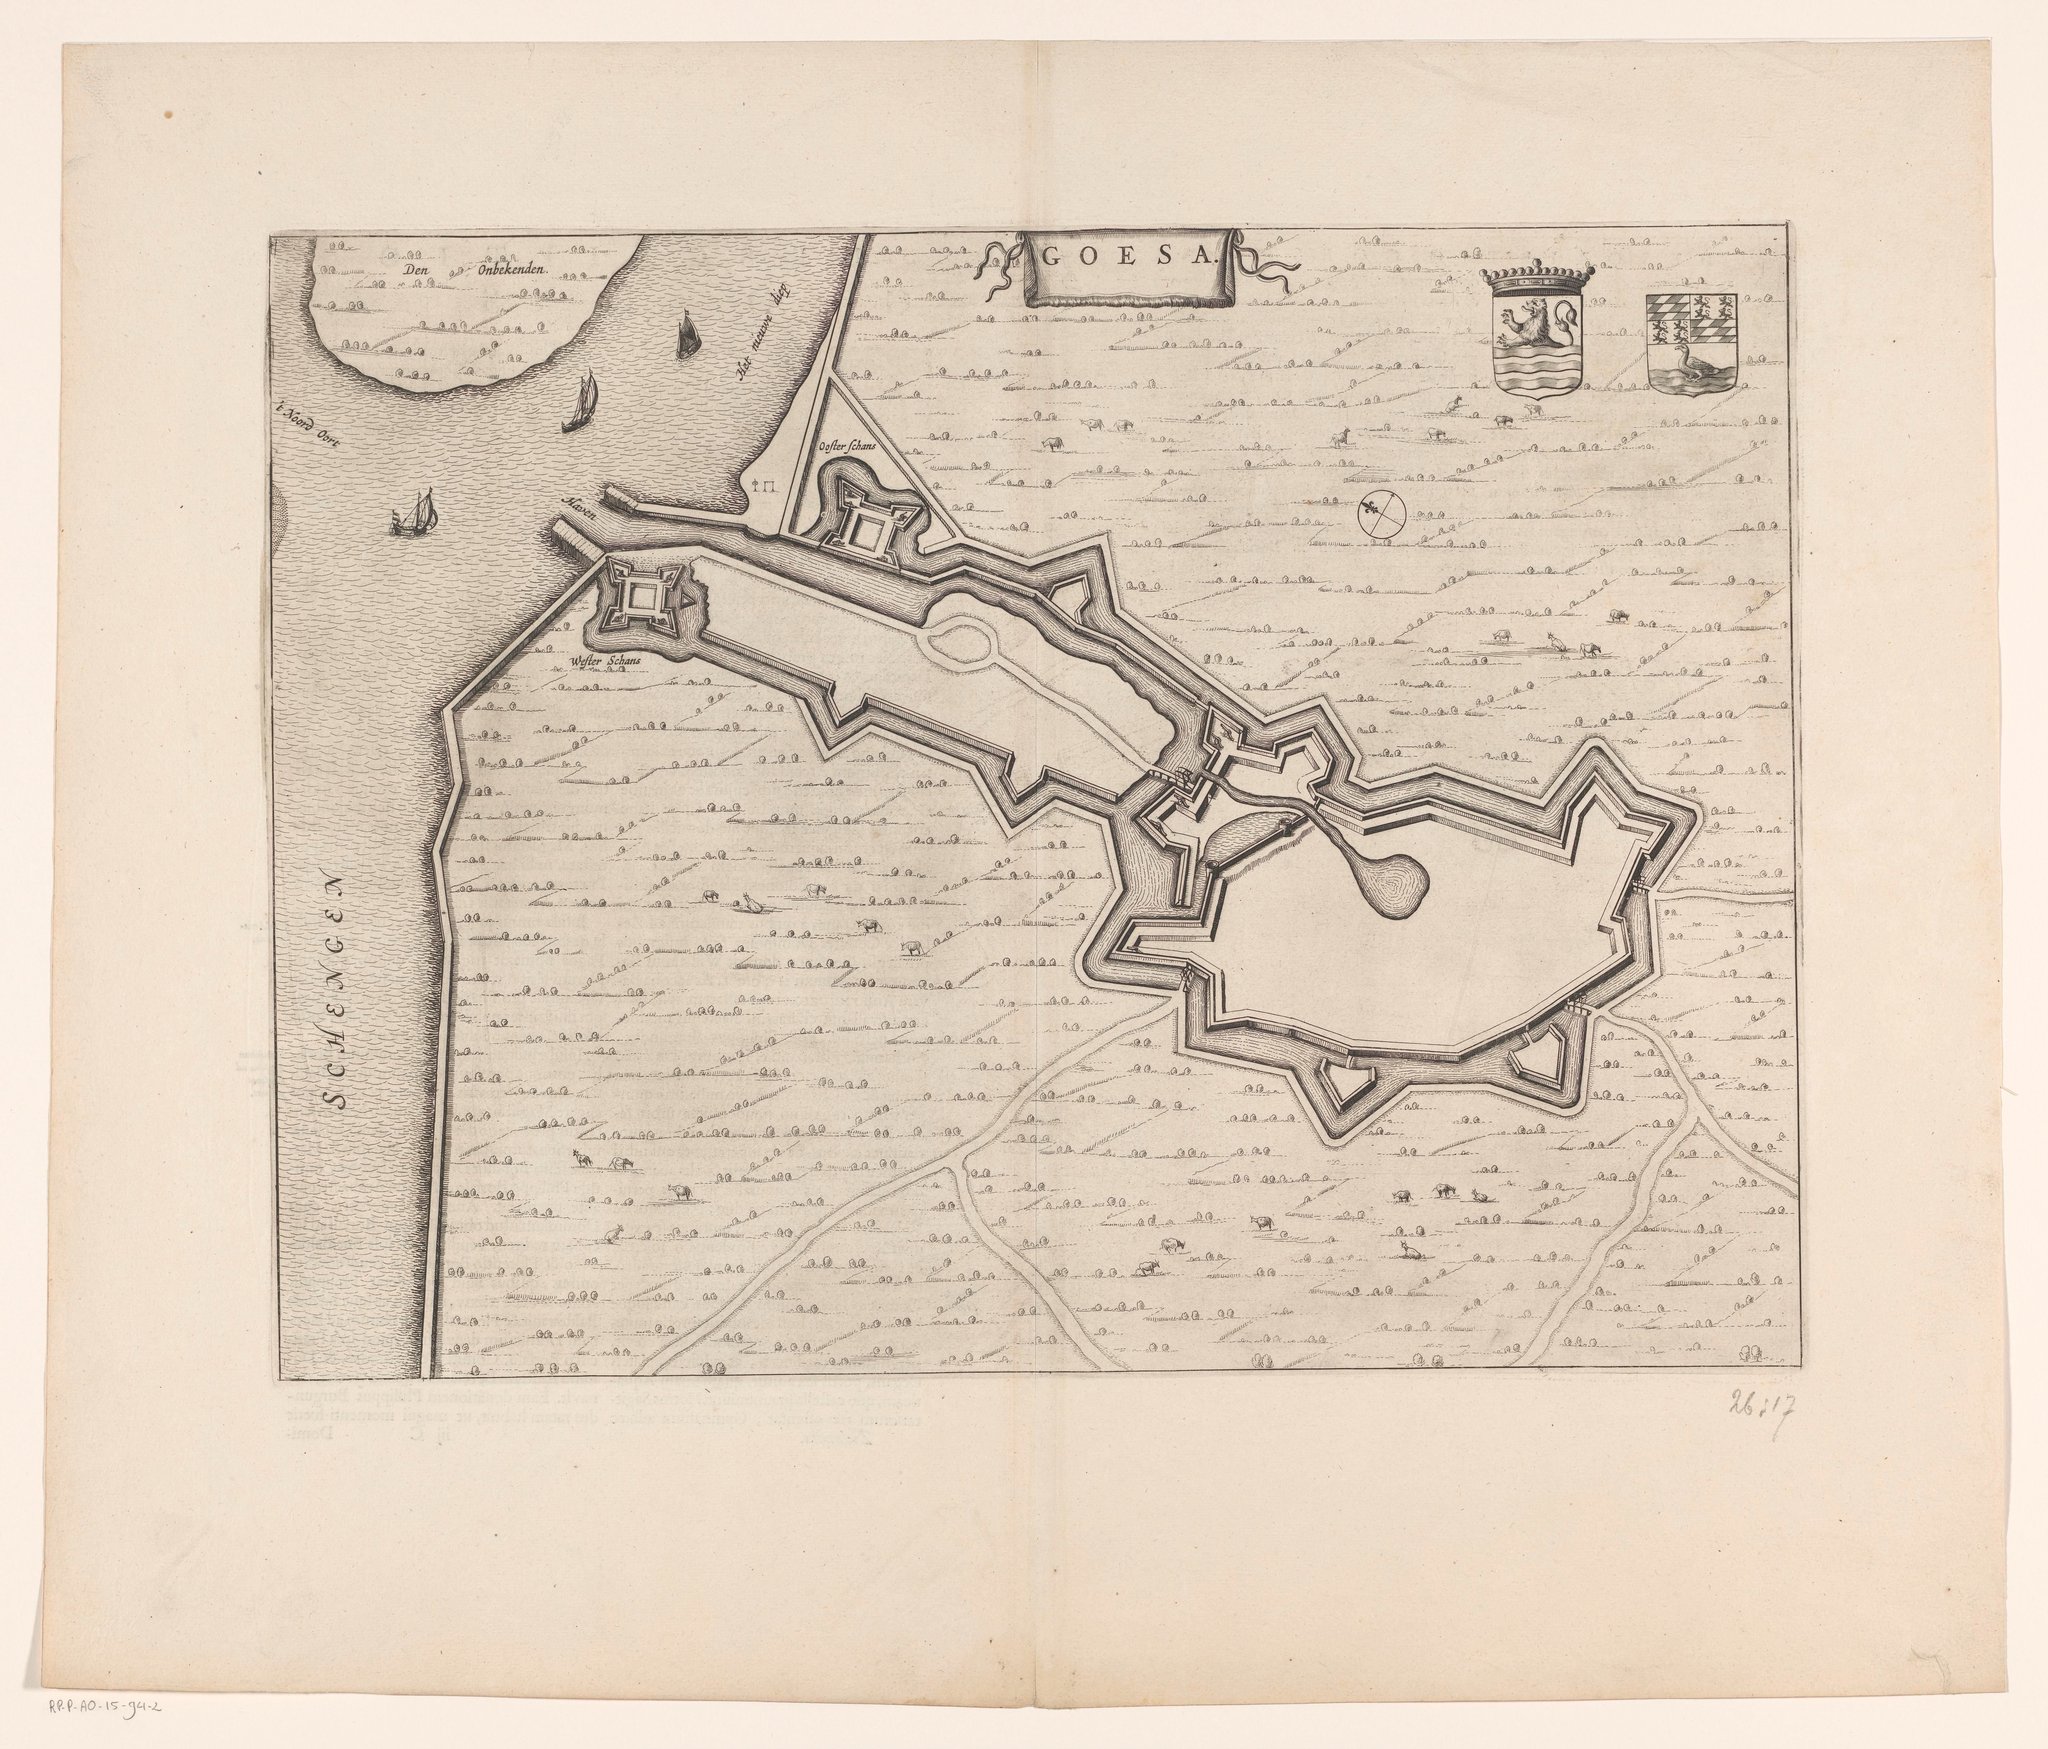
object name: area plan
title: Vestingplattegrond van Goes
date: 1652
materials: paper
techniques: engraving, etching, letterpress printing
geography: amsterdam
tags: coat of arms (as symbol of the state, etc.) (+ city; municipal), maps of cities, coat of arms (as symbol of the state, etc.) (+ province; provincial)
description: Prent gebruikt in: Blaeu, Johannes Willemszoon. Novum ac magnum theatrum urbium Belgicae (...). 2 delen. 3e druk. Amsterdam: Johannes Willemszoon Blaeu, 1652, dl. 1.